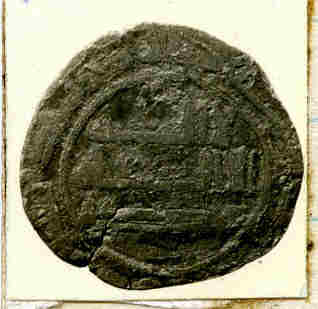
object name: coin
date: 718-814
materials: copper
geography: iran